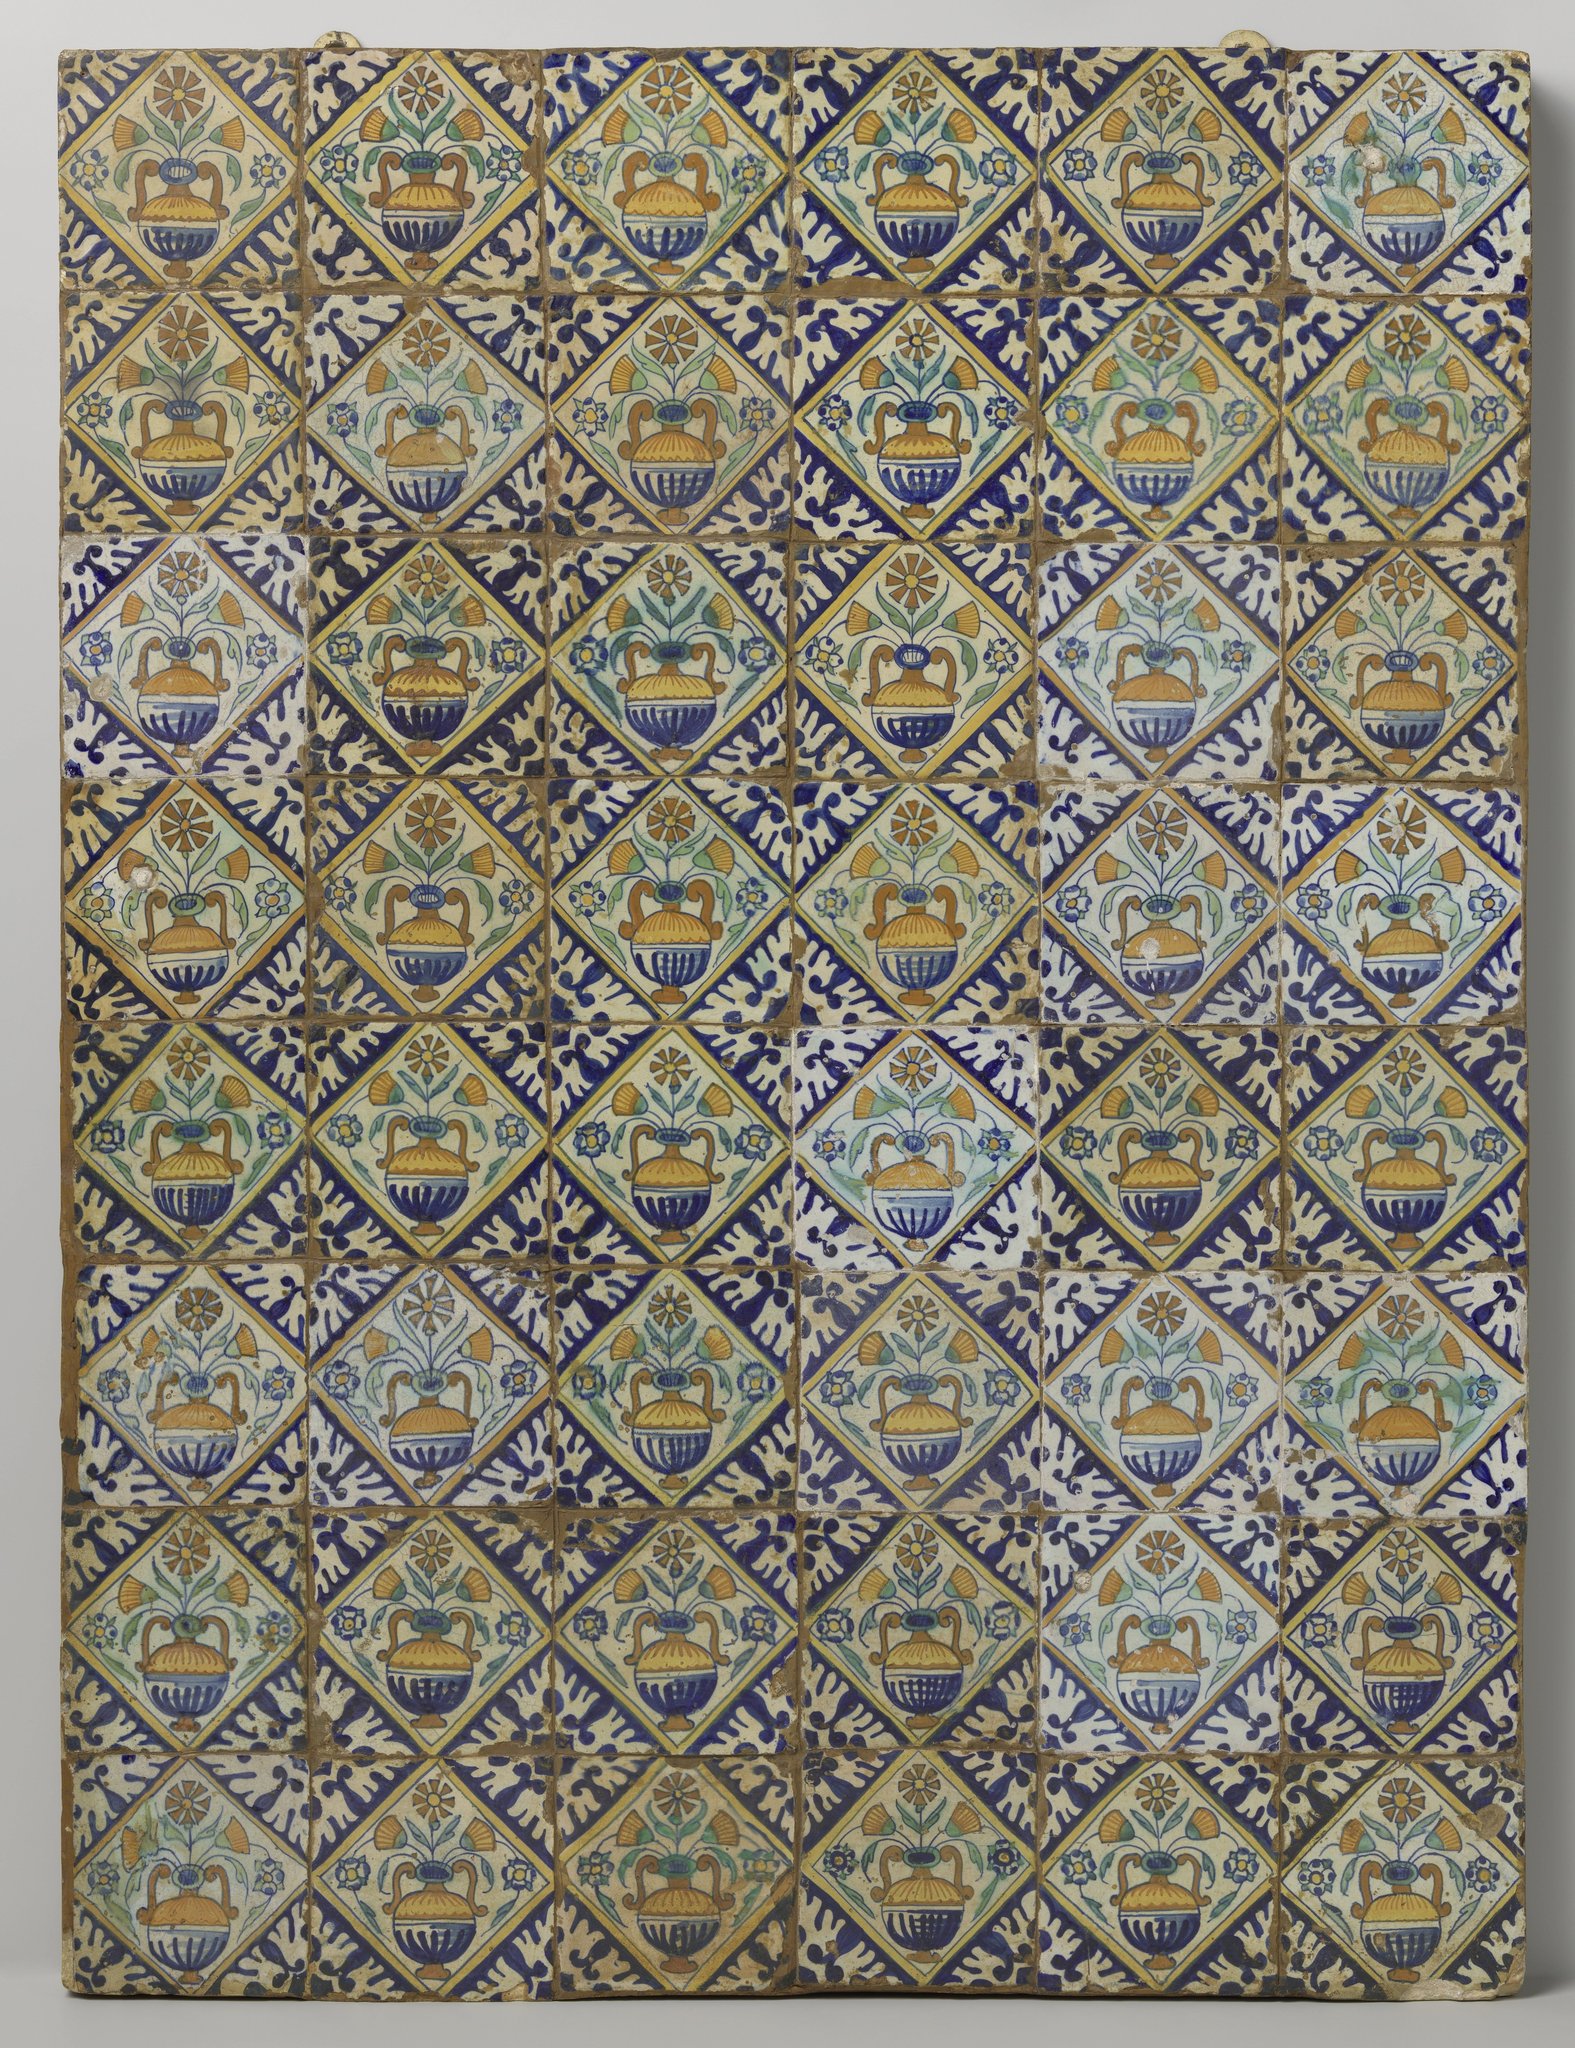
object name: tile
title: Veld van achtenveertig tegels met bloempotten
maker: Anonymous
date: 1580-1625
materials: earthenware, glaze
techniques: maiolica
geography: netherlands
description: Veld van achtenveertig tegels (8 x 6) elk met een veelkleurige (blauw, oranje, groen en geel) bloempot binnen een kwadraat omlijsting. In de hoeken, ornament in vultechniek.